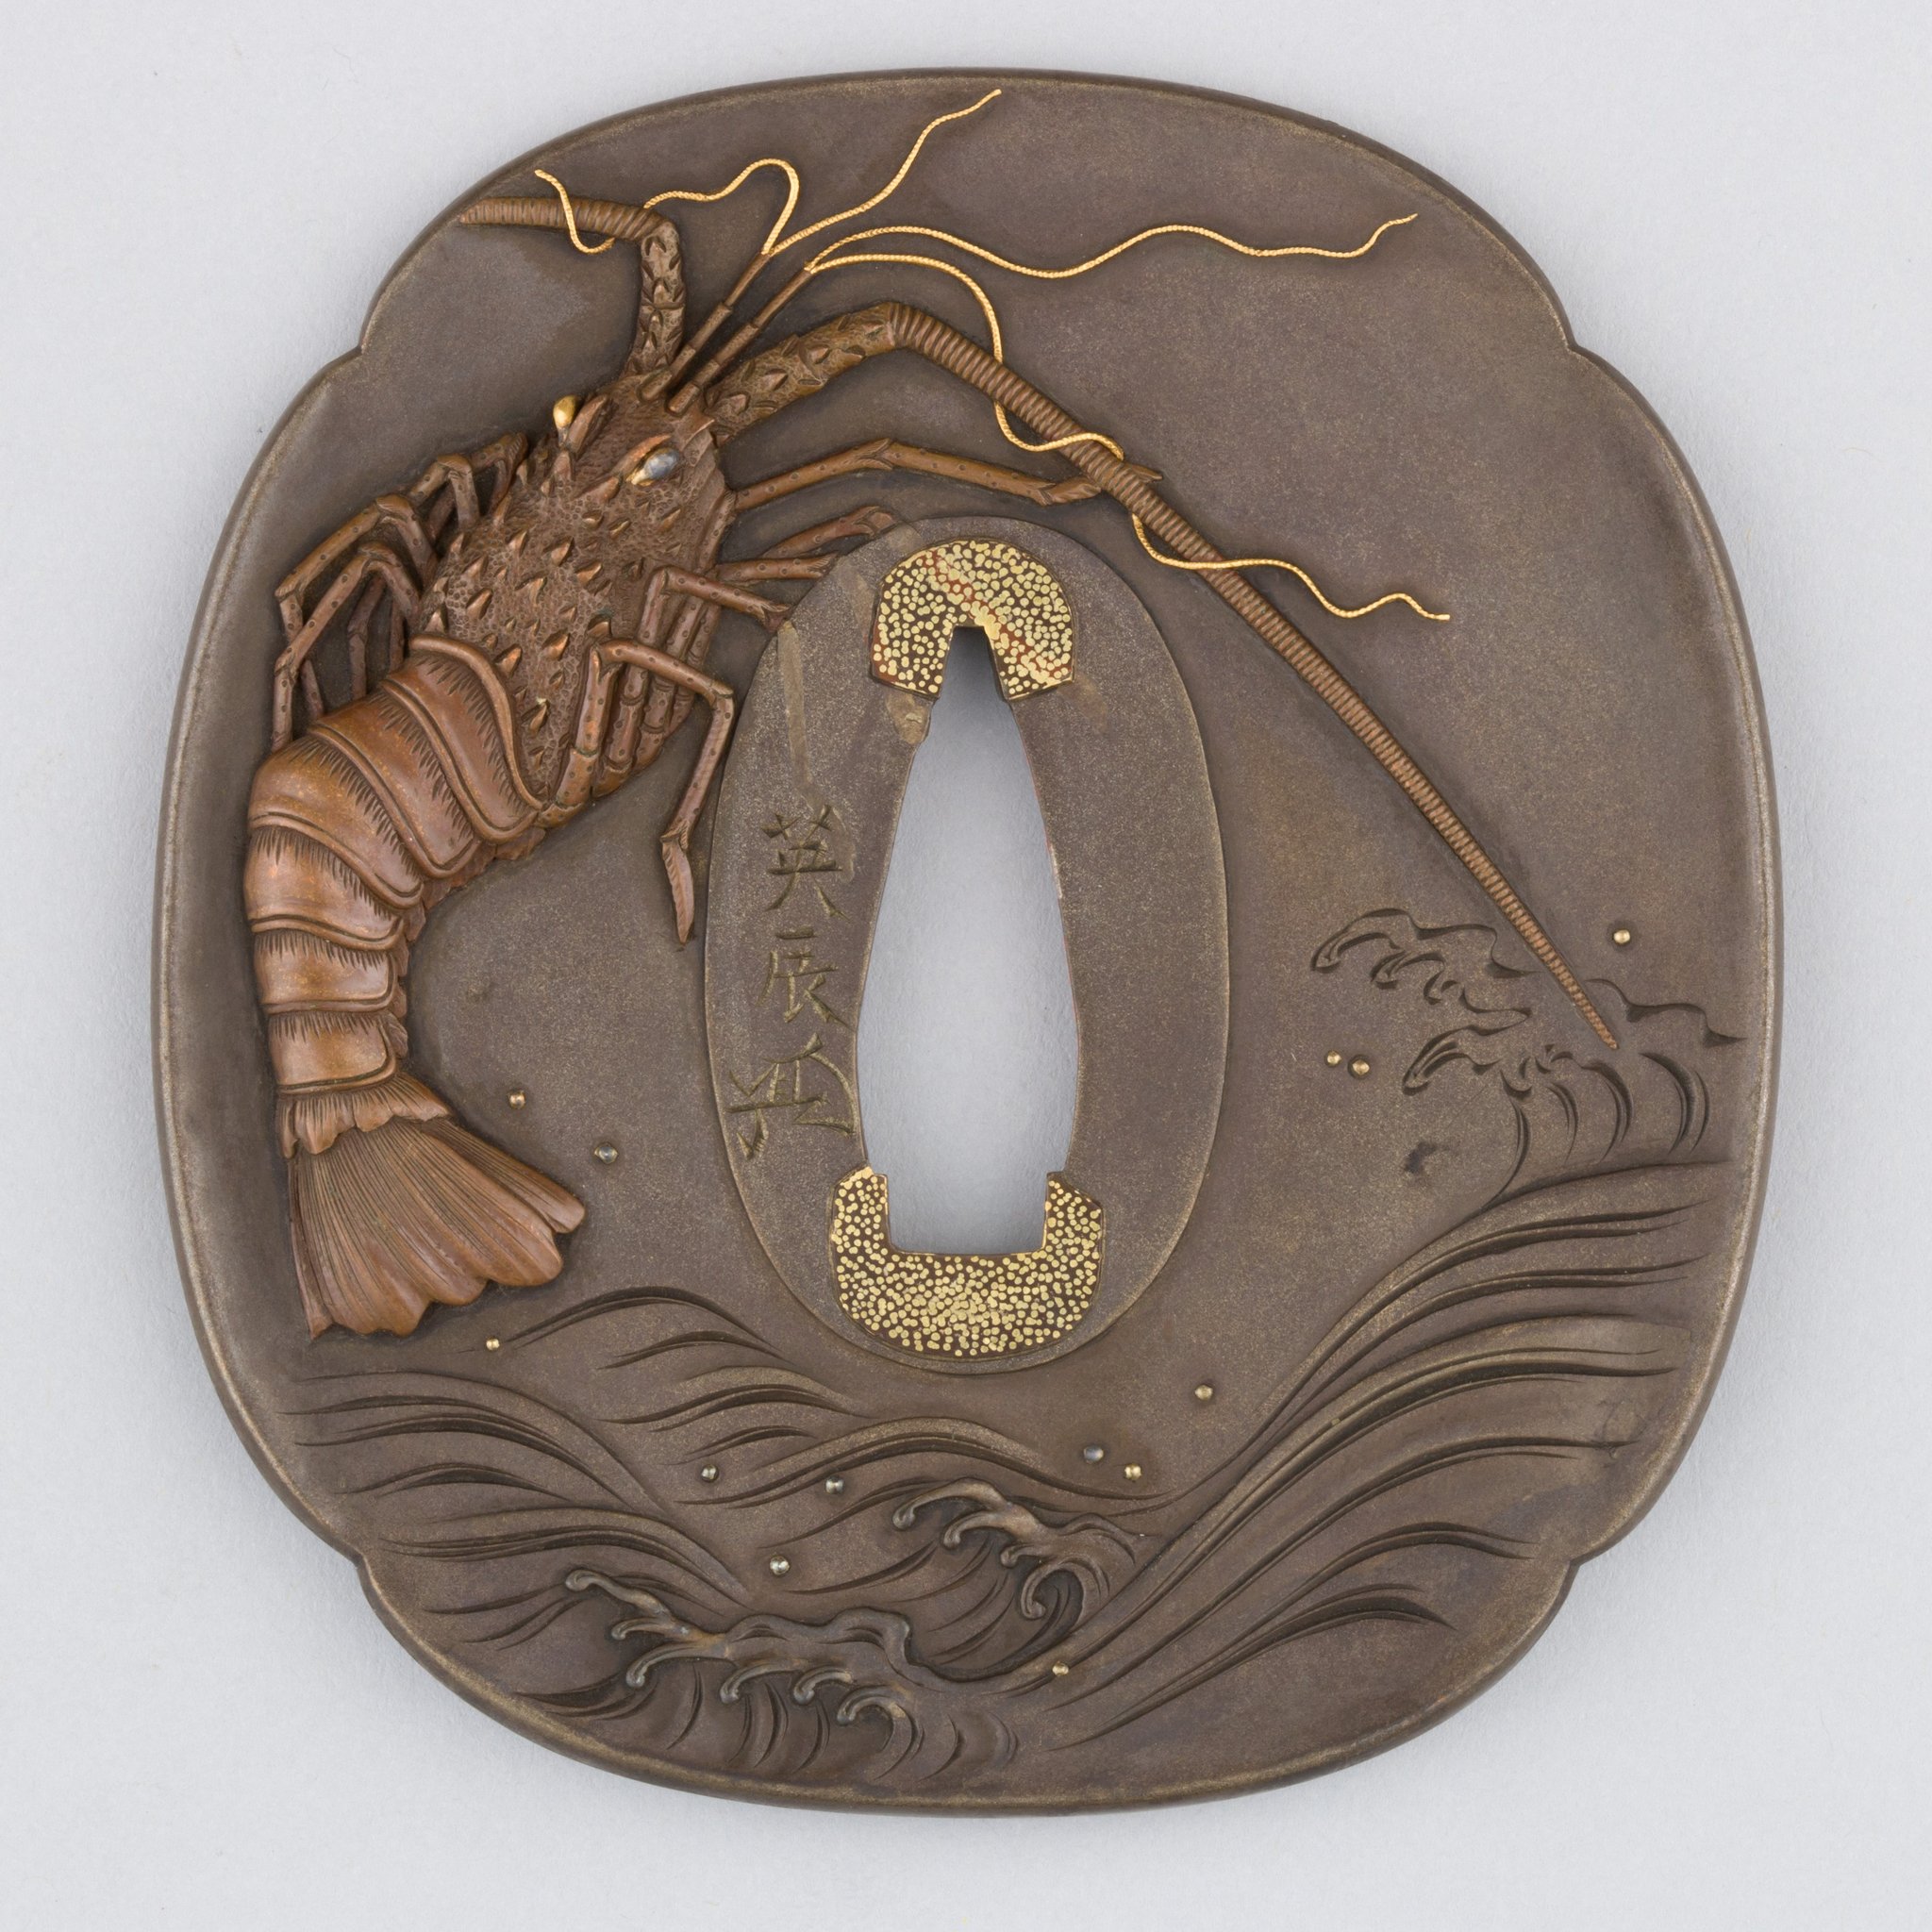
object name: sword guard tsuba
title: Sword Guard (Tsuba)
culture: japanese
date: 1615-1868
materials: copper, gold alloy, silver alloy, gold, silver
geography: japan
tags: lobsters,waves